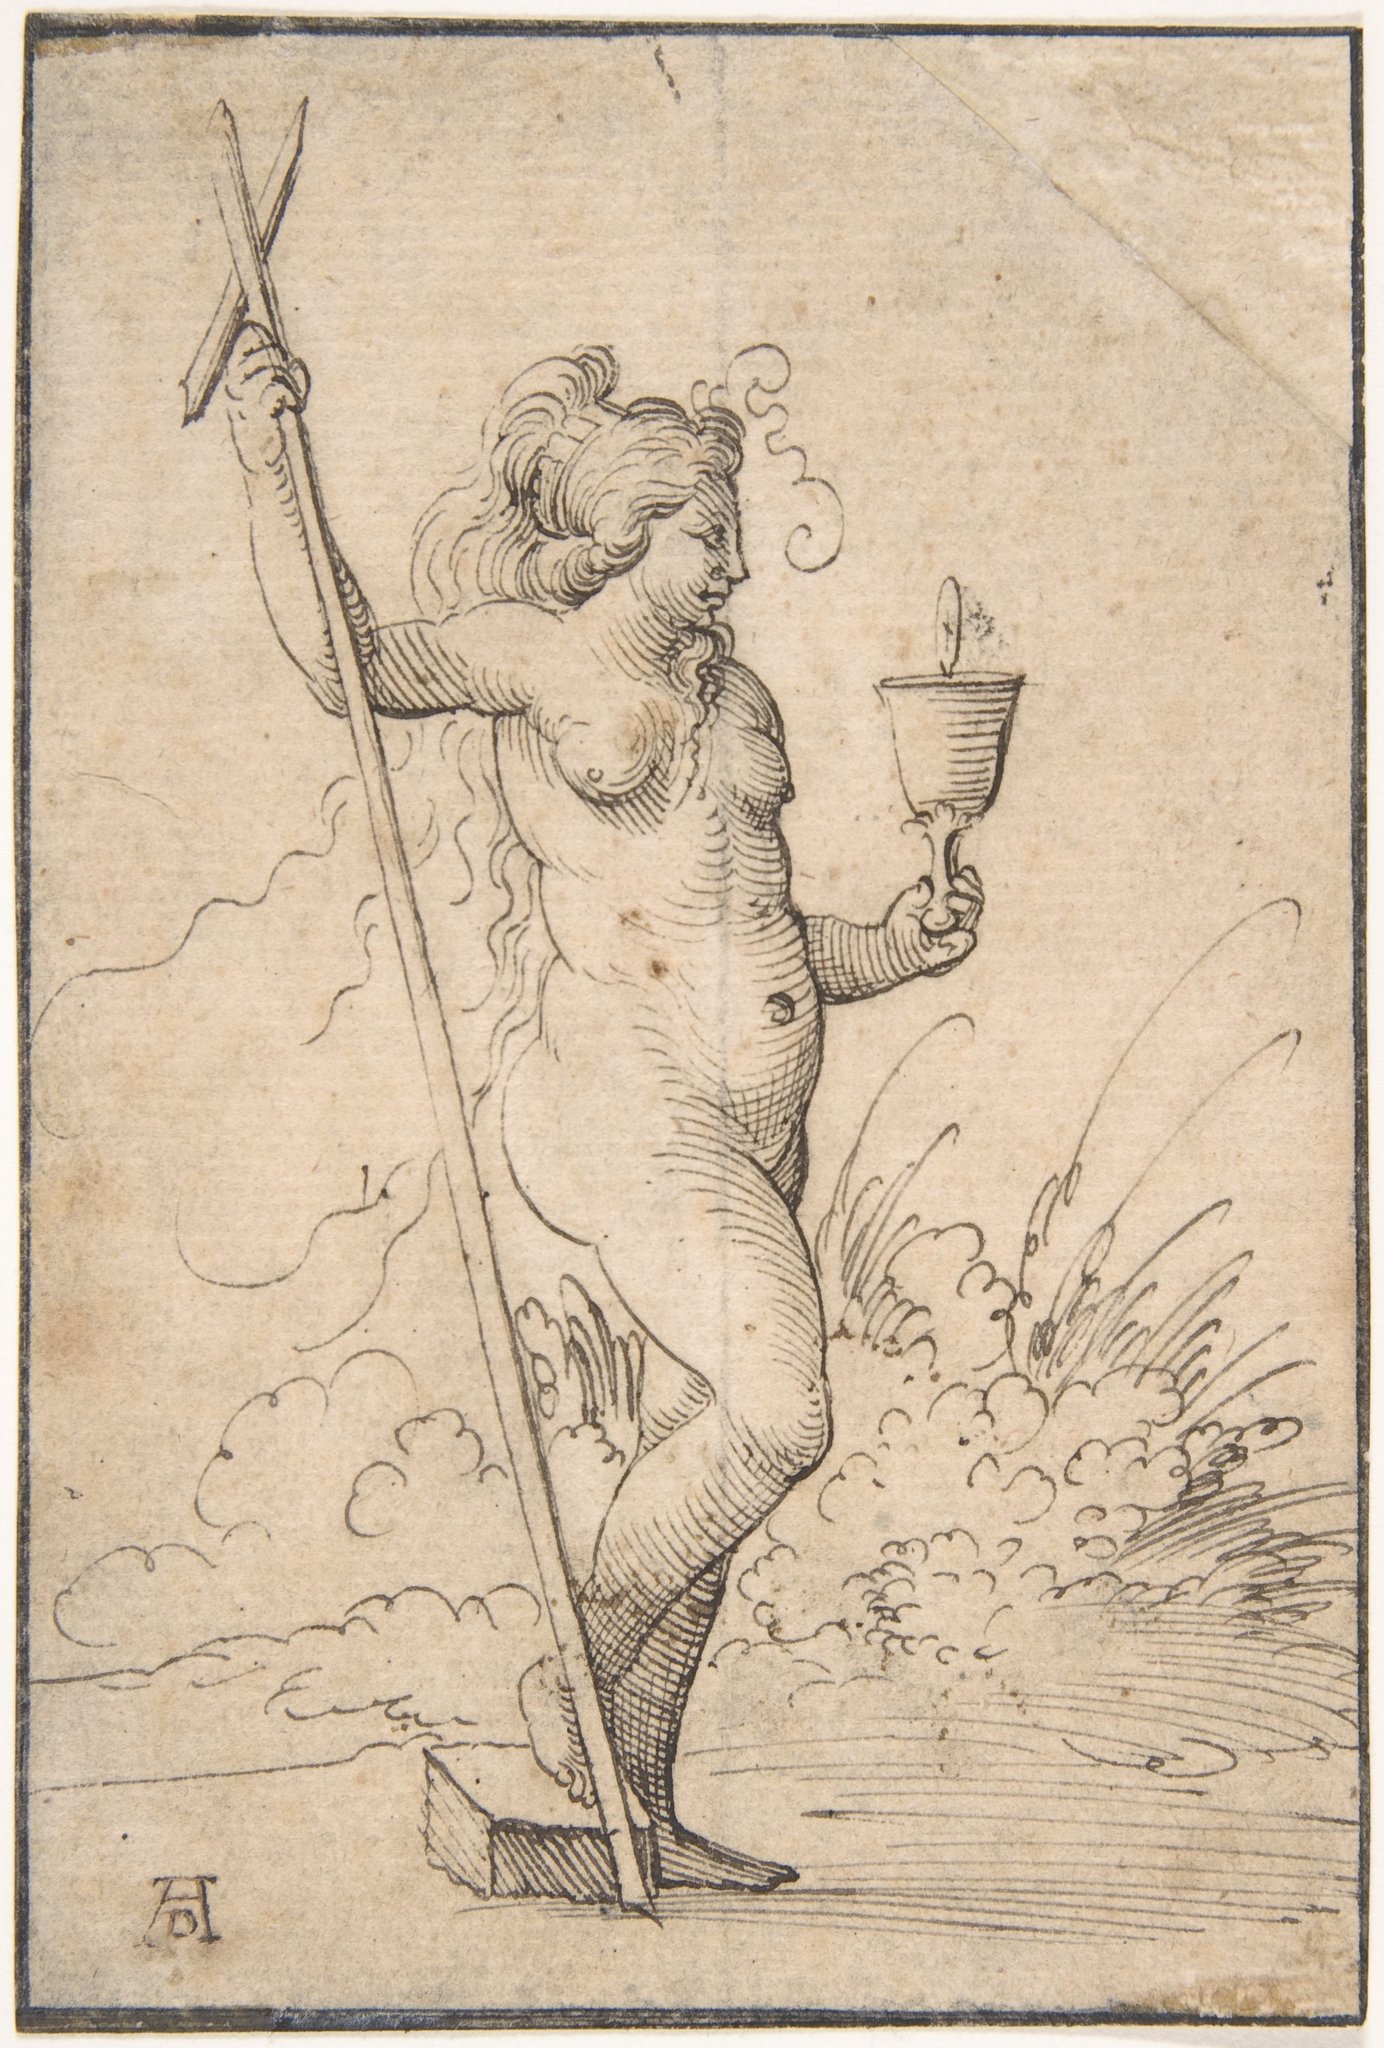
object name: drawing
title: Faith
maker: anonymous, german, 16th century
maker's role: artist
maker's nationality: german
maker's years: 1500-1600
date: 1501-1600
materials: ink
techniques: pen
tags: female nudes,cross